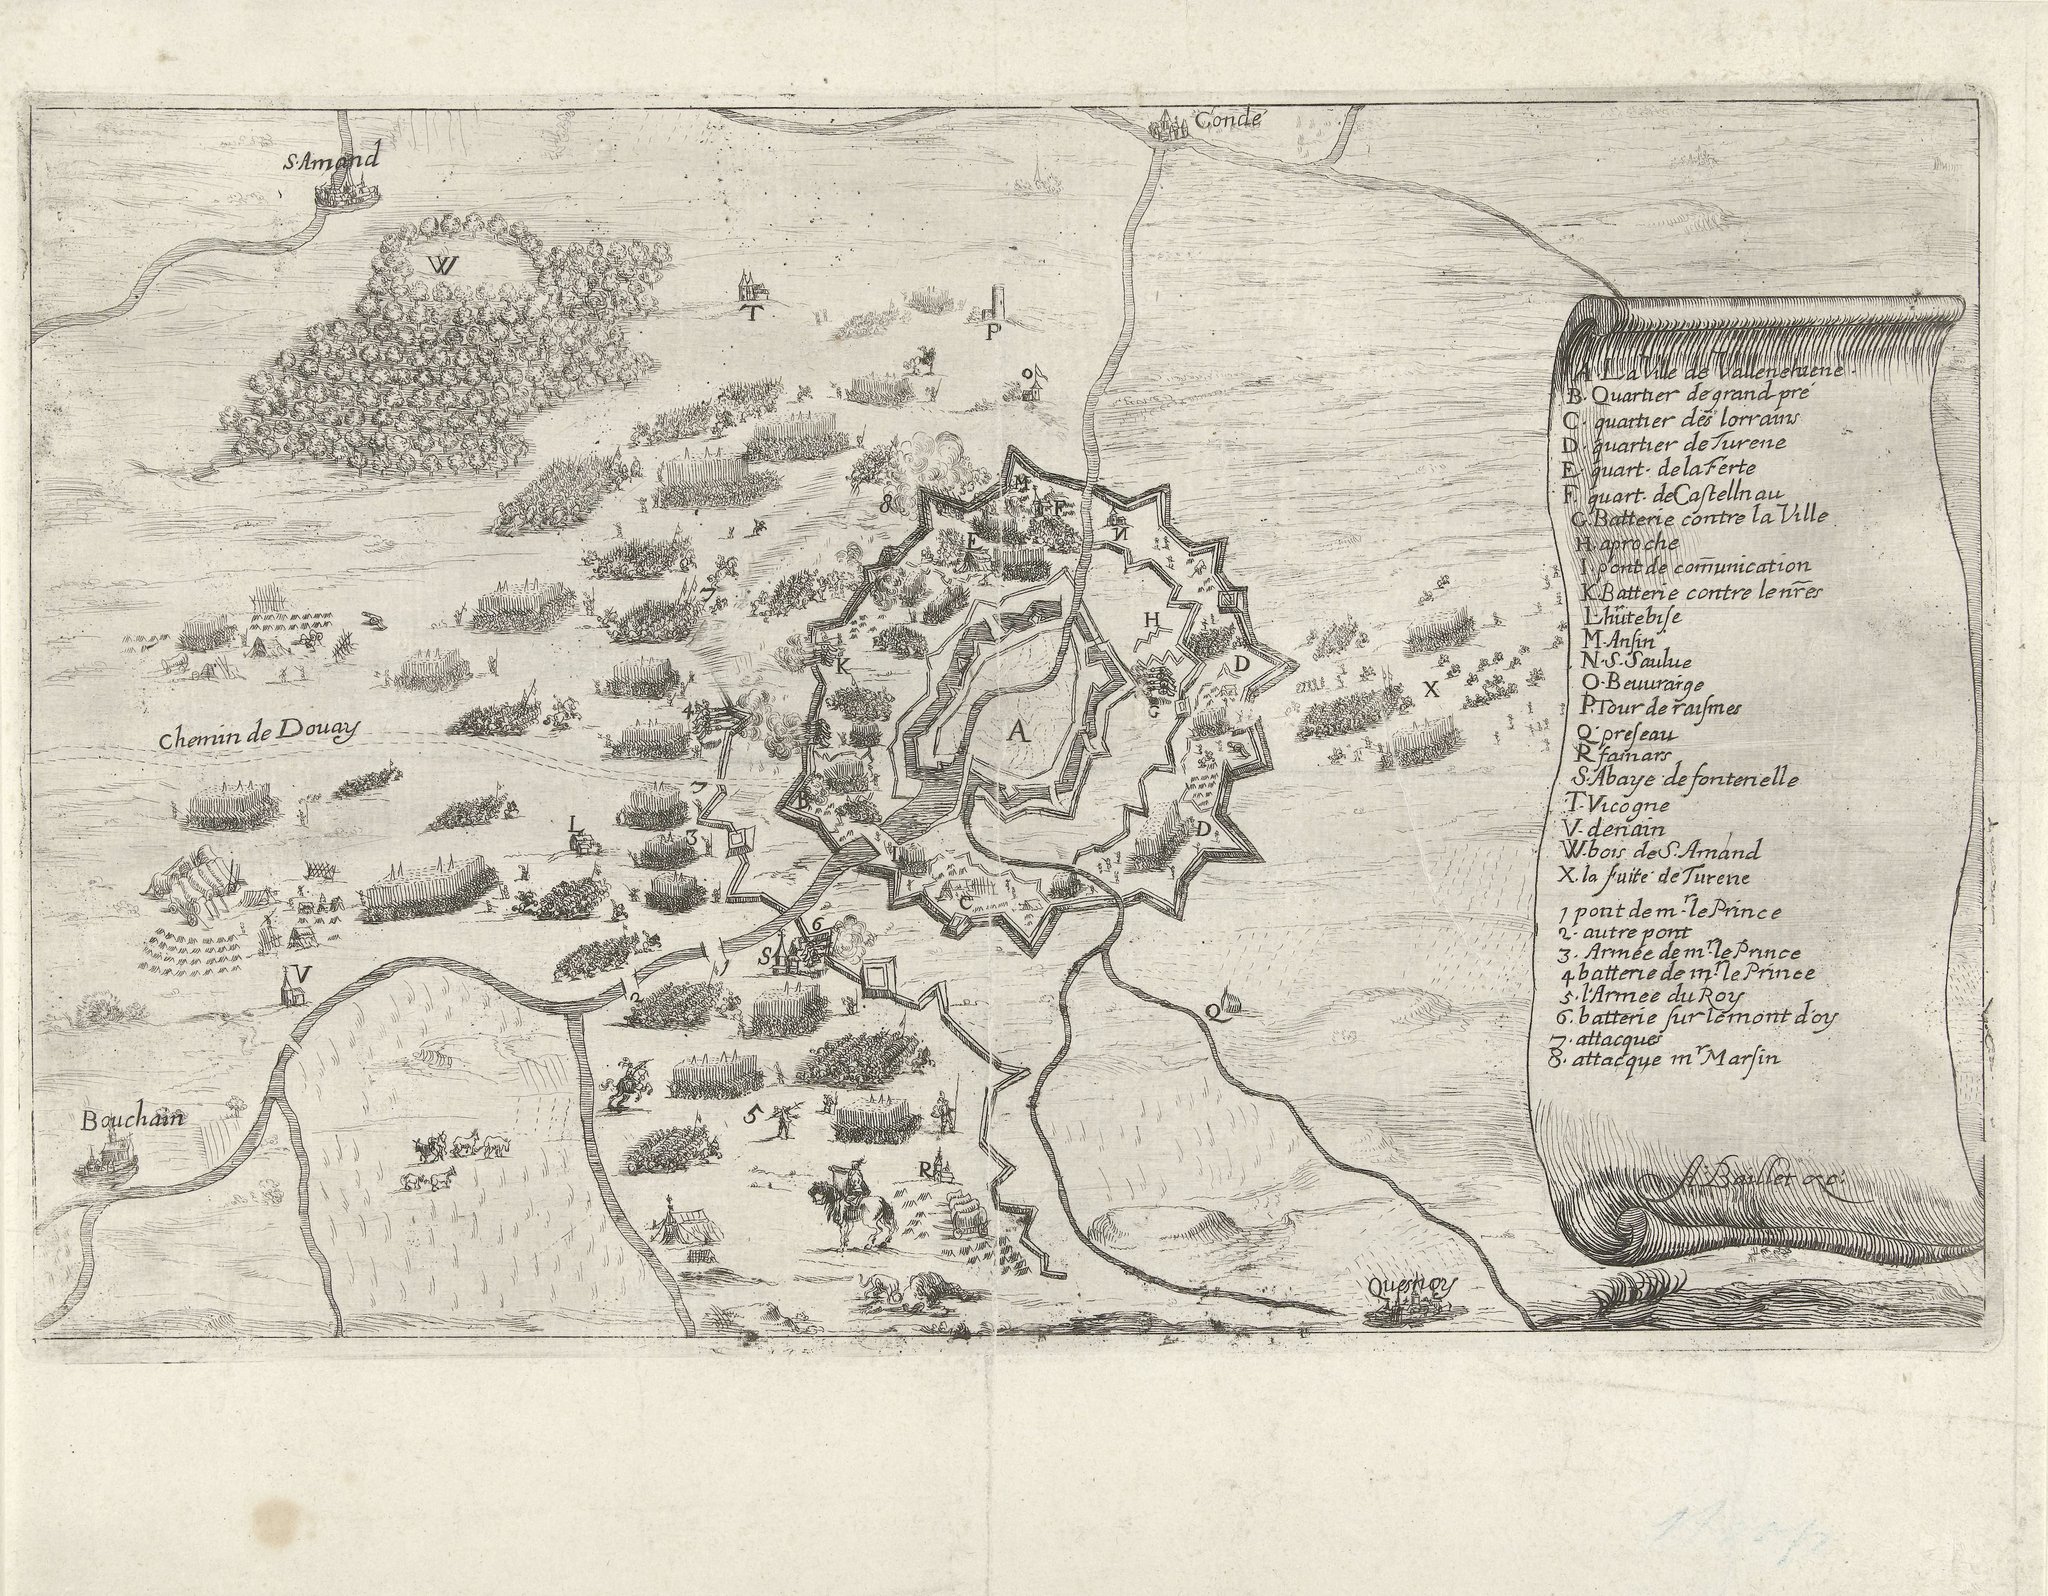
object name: history print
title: Beleg en ontzet van Valenciennes, 1656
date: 1656-1660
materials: paper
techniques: etching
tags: paris, lodewijk ii de bourbon-condé (hertog van enghien), raising the siege with outside assistance, relief, maps of separate countries or regions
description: Kaartje van de belegering van Valenciennes door de Fransen onder Turenne en Castelnau en het ontzet door Spaanse troepen onder de prins van Condé op 16 juli 1656. Rechts een banderol met de legenda A-8 in het Frans.